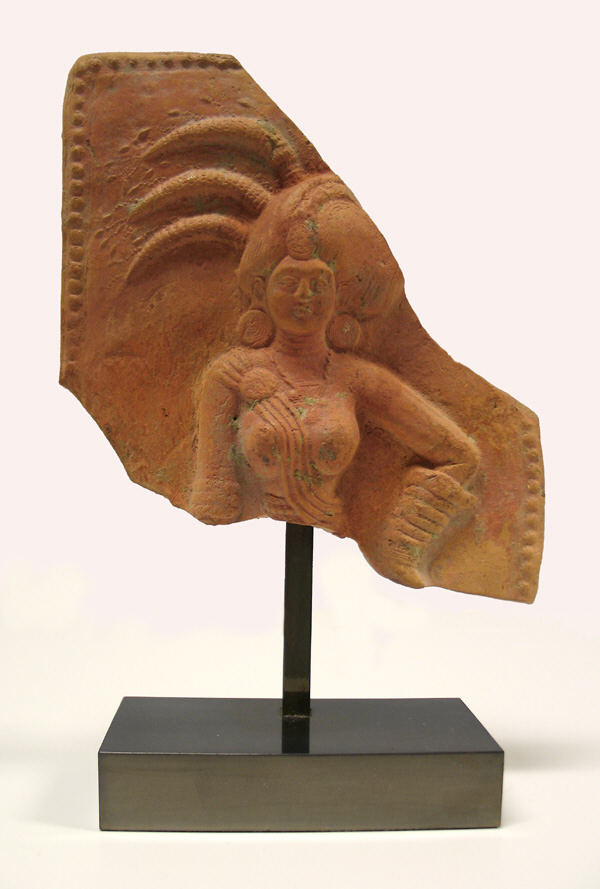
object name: plaque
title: Plaque with a Royal Woman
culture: indian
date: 100-1 BCE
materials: terracotta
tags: women